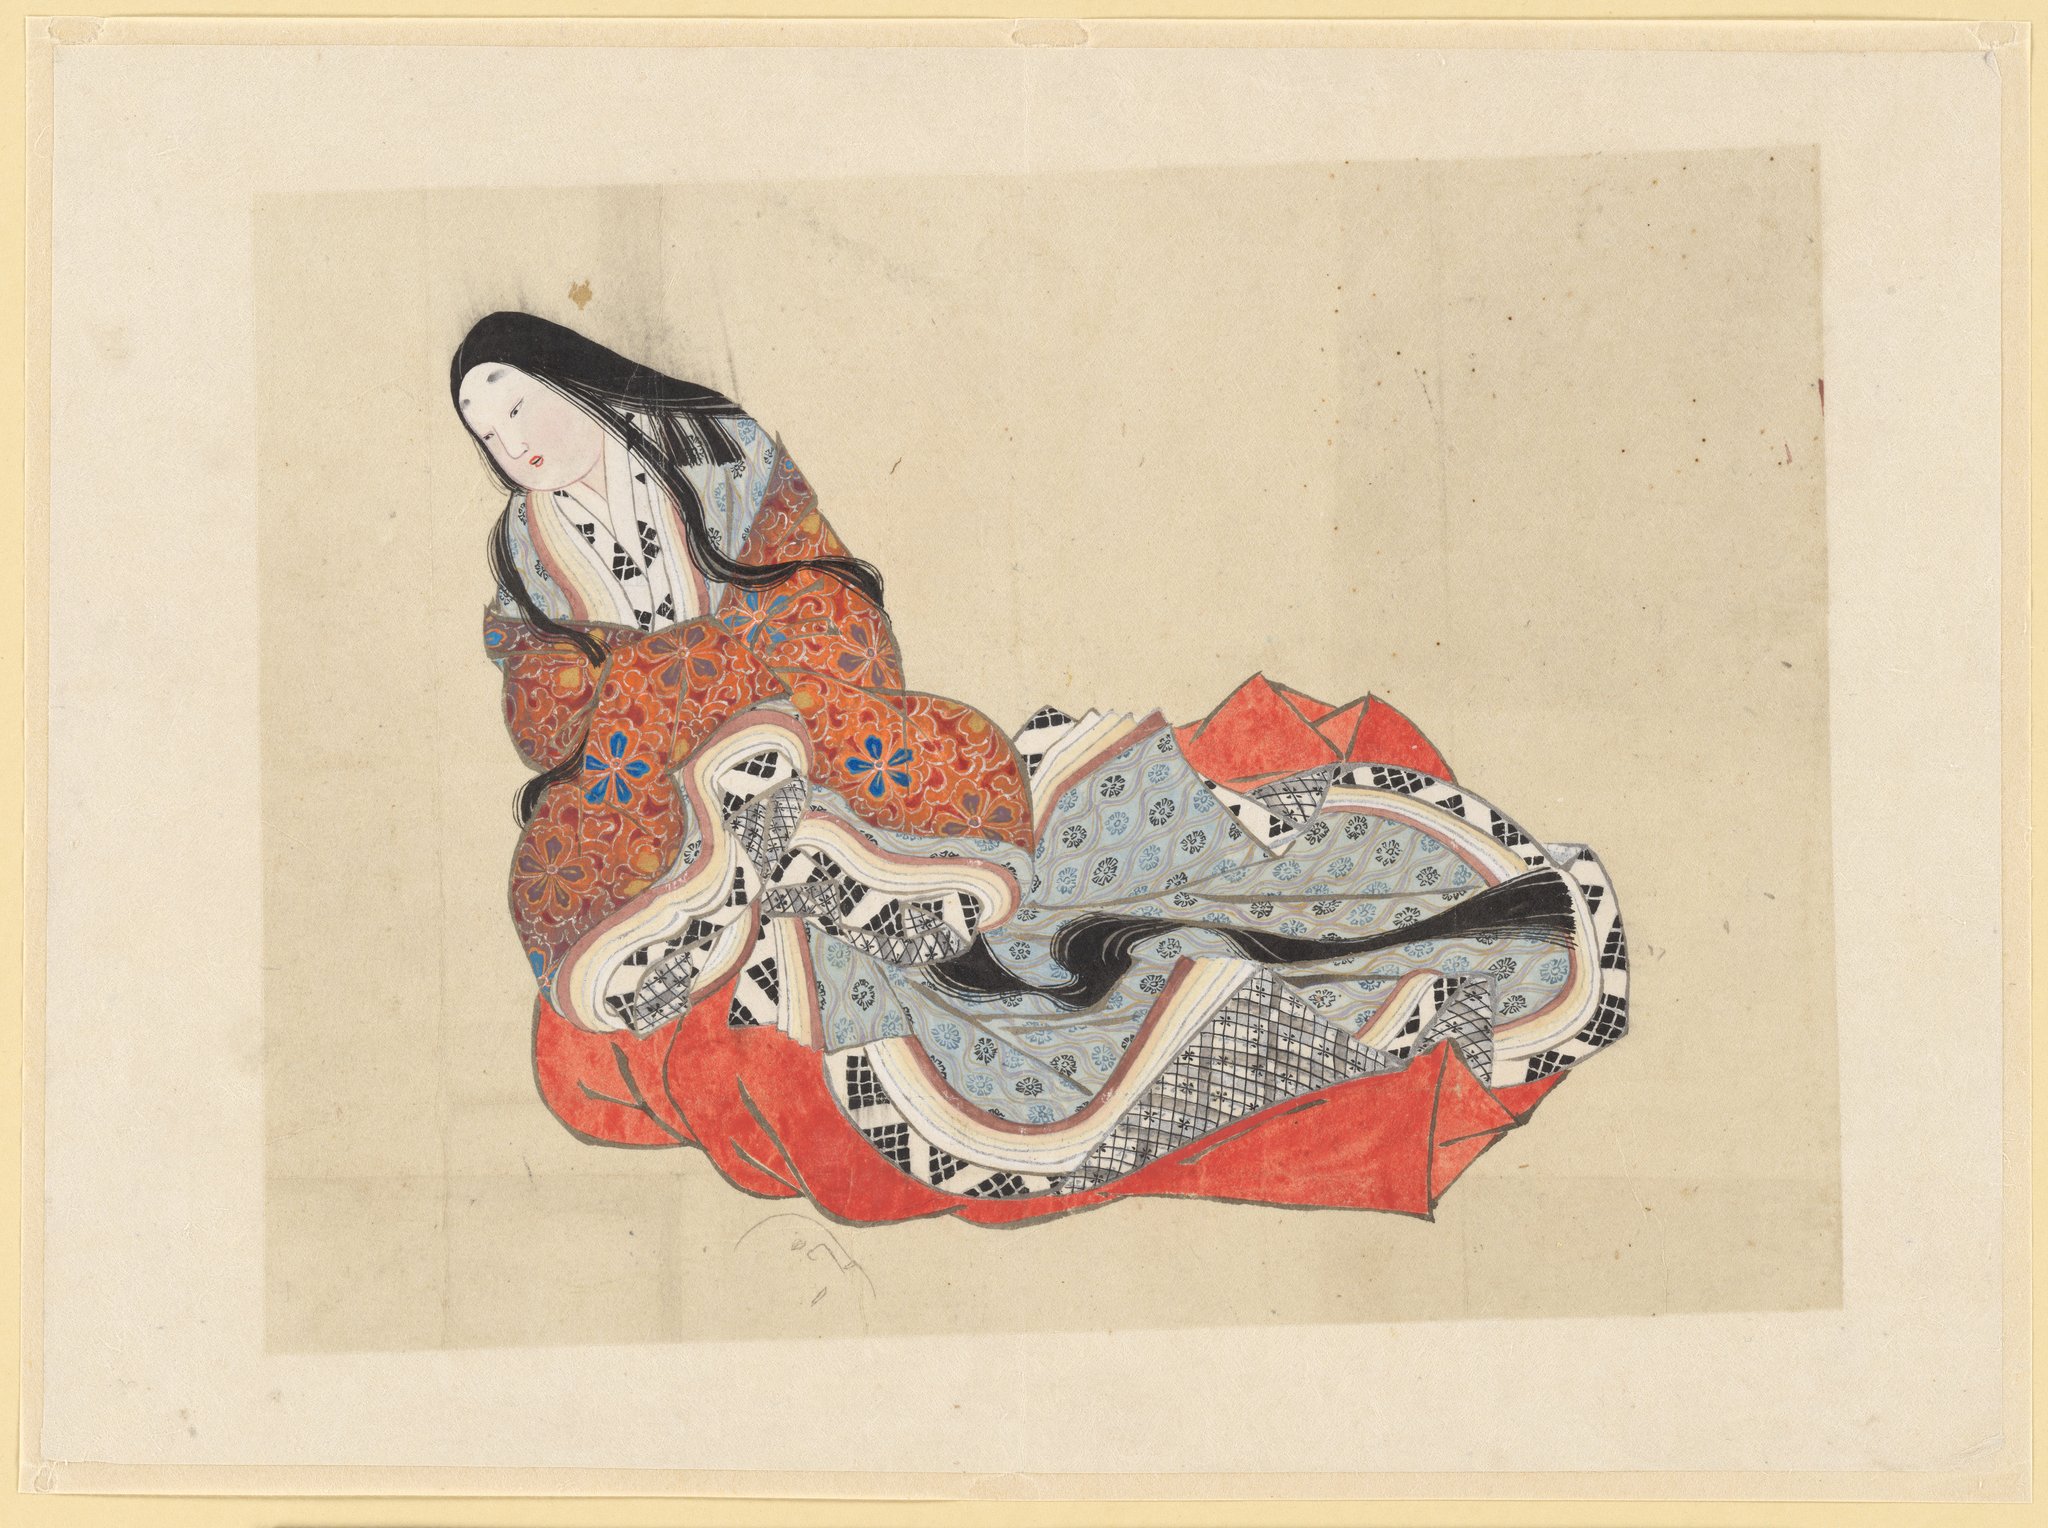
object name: painting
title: Court Lady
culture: japanese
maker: katsushika hokusai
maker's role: artist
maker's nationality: japanese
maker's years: 1760-1849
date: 1701-1900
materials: ink, paper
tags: women